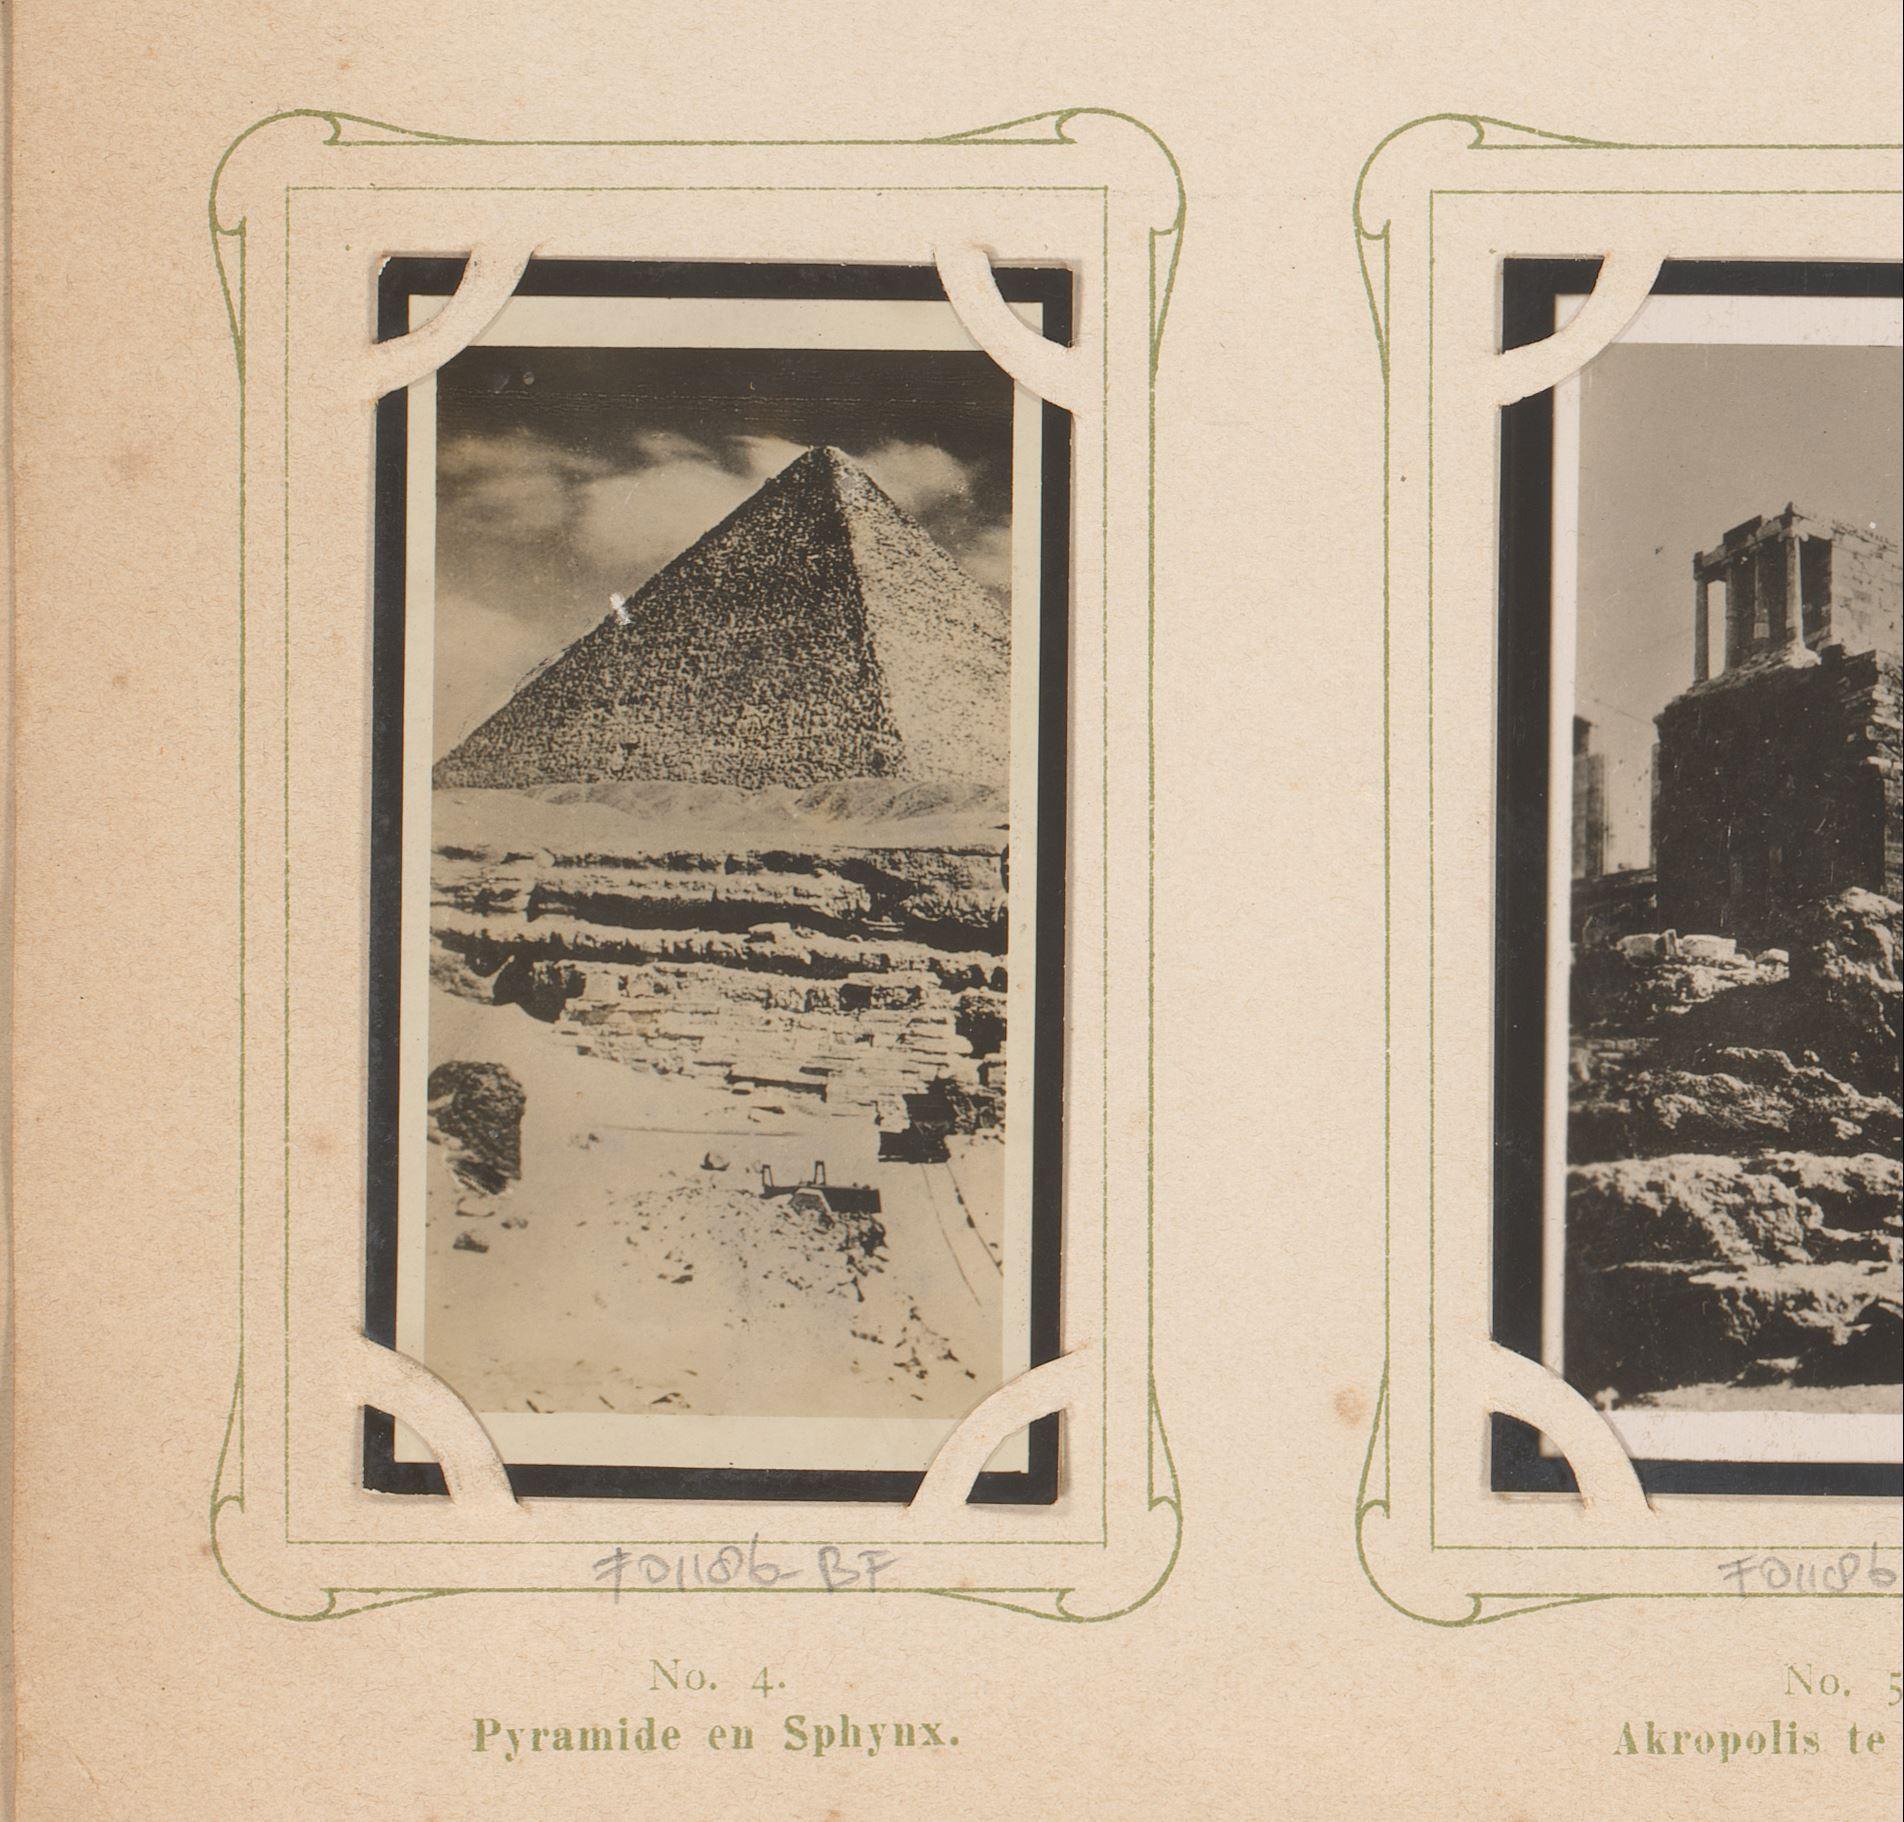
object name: photograph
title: Gezicht op één van de Piramides van Gizeh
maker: Anonymous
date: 1904-1905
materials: photographic support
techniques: gelatin silver print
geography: cairo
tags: quadrangular pyramid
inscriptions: inscription: ‘No. 4./ Pyramide en Sphynx.’